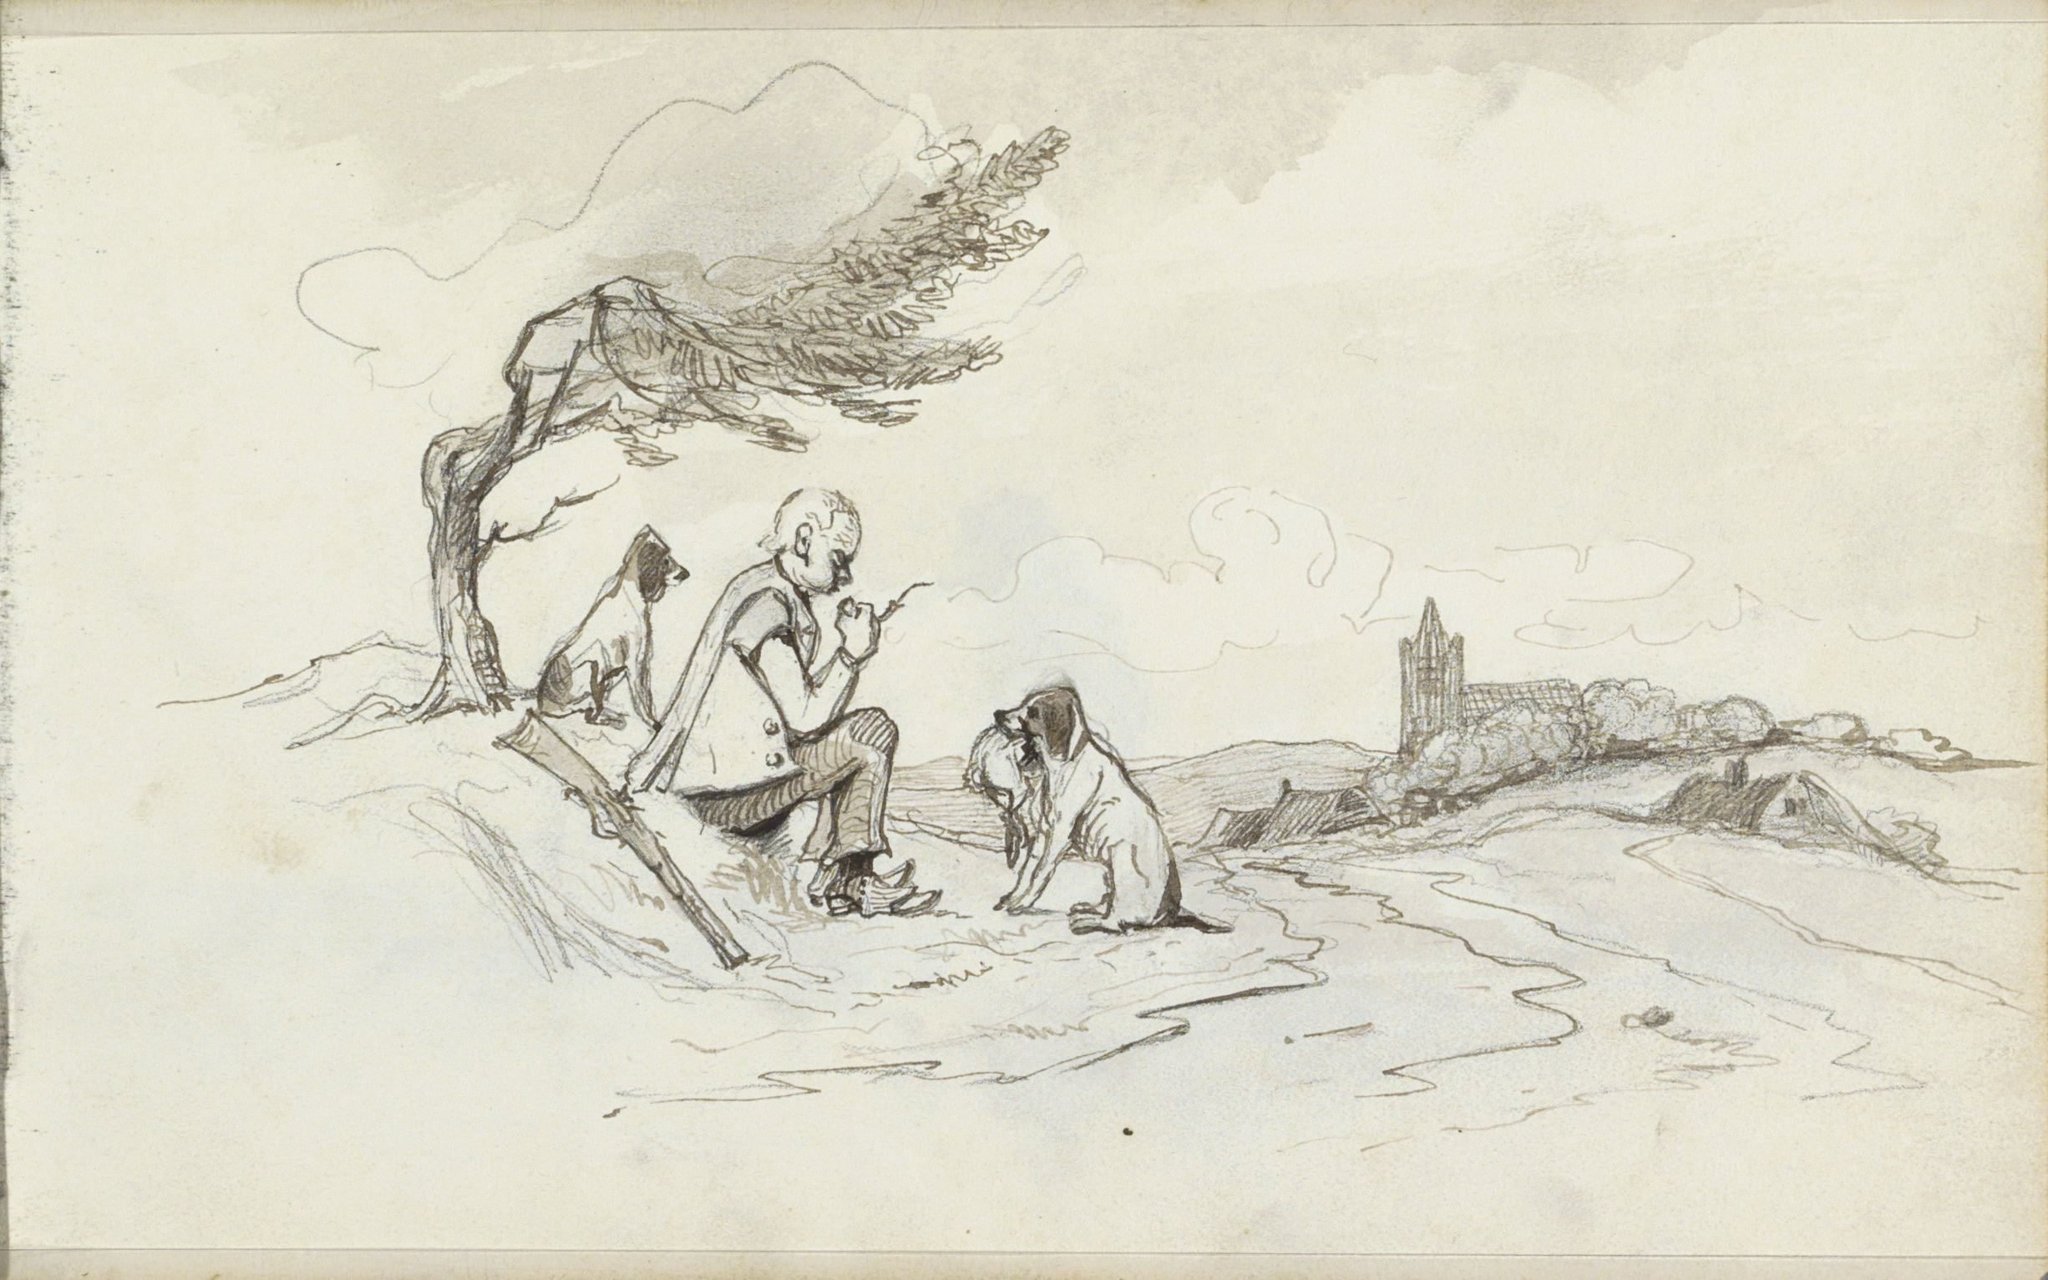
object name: sketchbook leaf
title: Landschap met een zittende jager en zijn honden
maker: johannes tavenraat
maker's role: draughtsman, painter, print maker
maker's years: 1809-1881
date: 1843-1844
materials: ink, paper, pencil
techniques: brush, pen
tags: sitting figure, hunter, church (exterior), landscapes (+ landscape with figures, staffage), dog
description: Eén van de honden heeft wild, vermoedelijk een haas, in zijn bek. Op de achtergrond een kerktoren. Blad 12 recto uit een schetsboek met 38 bladen.